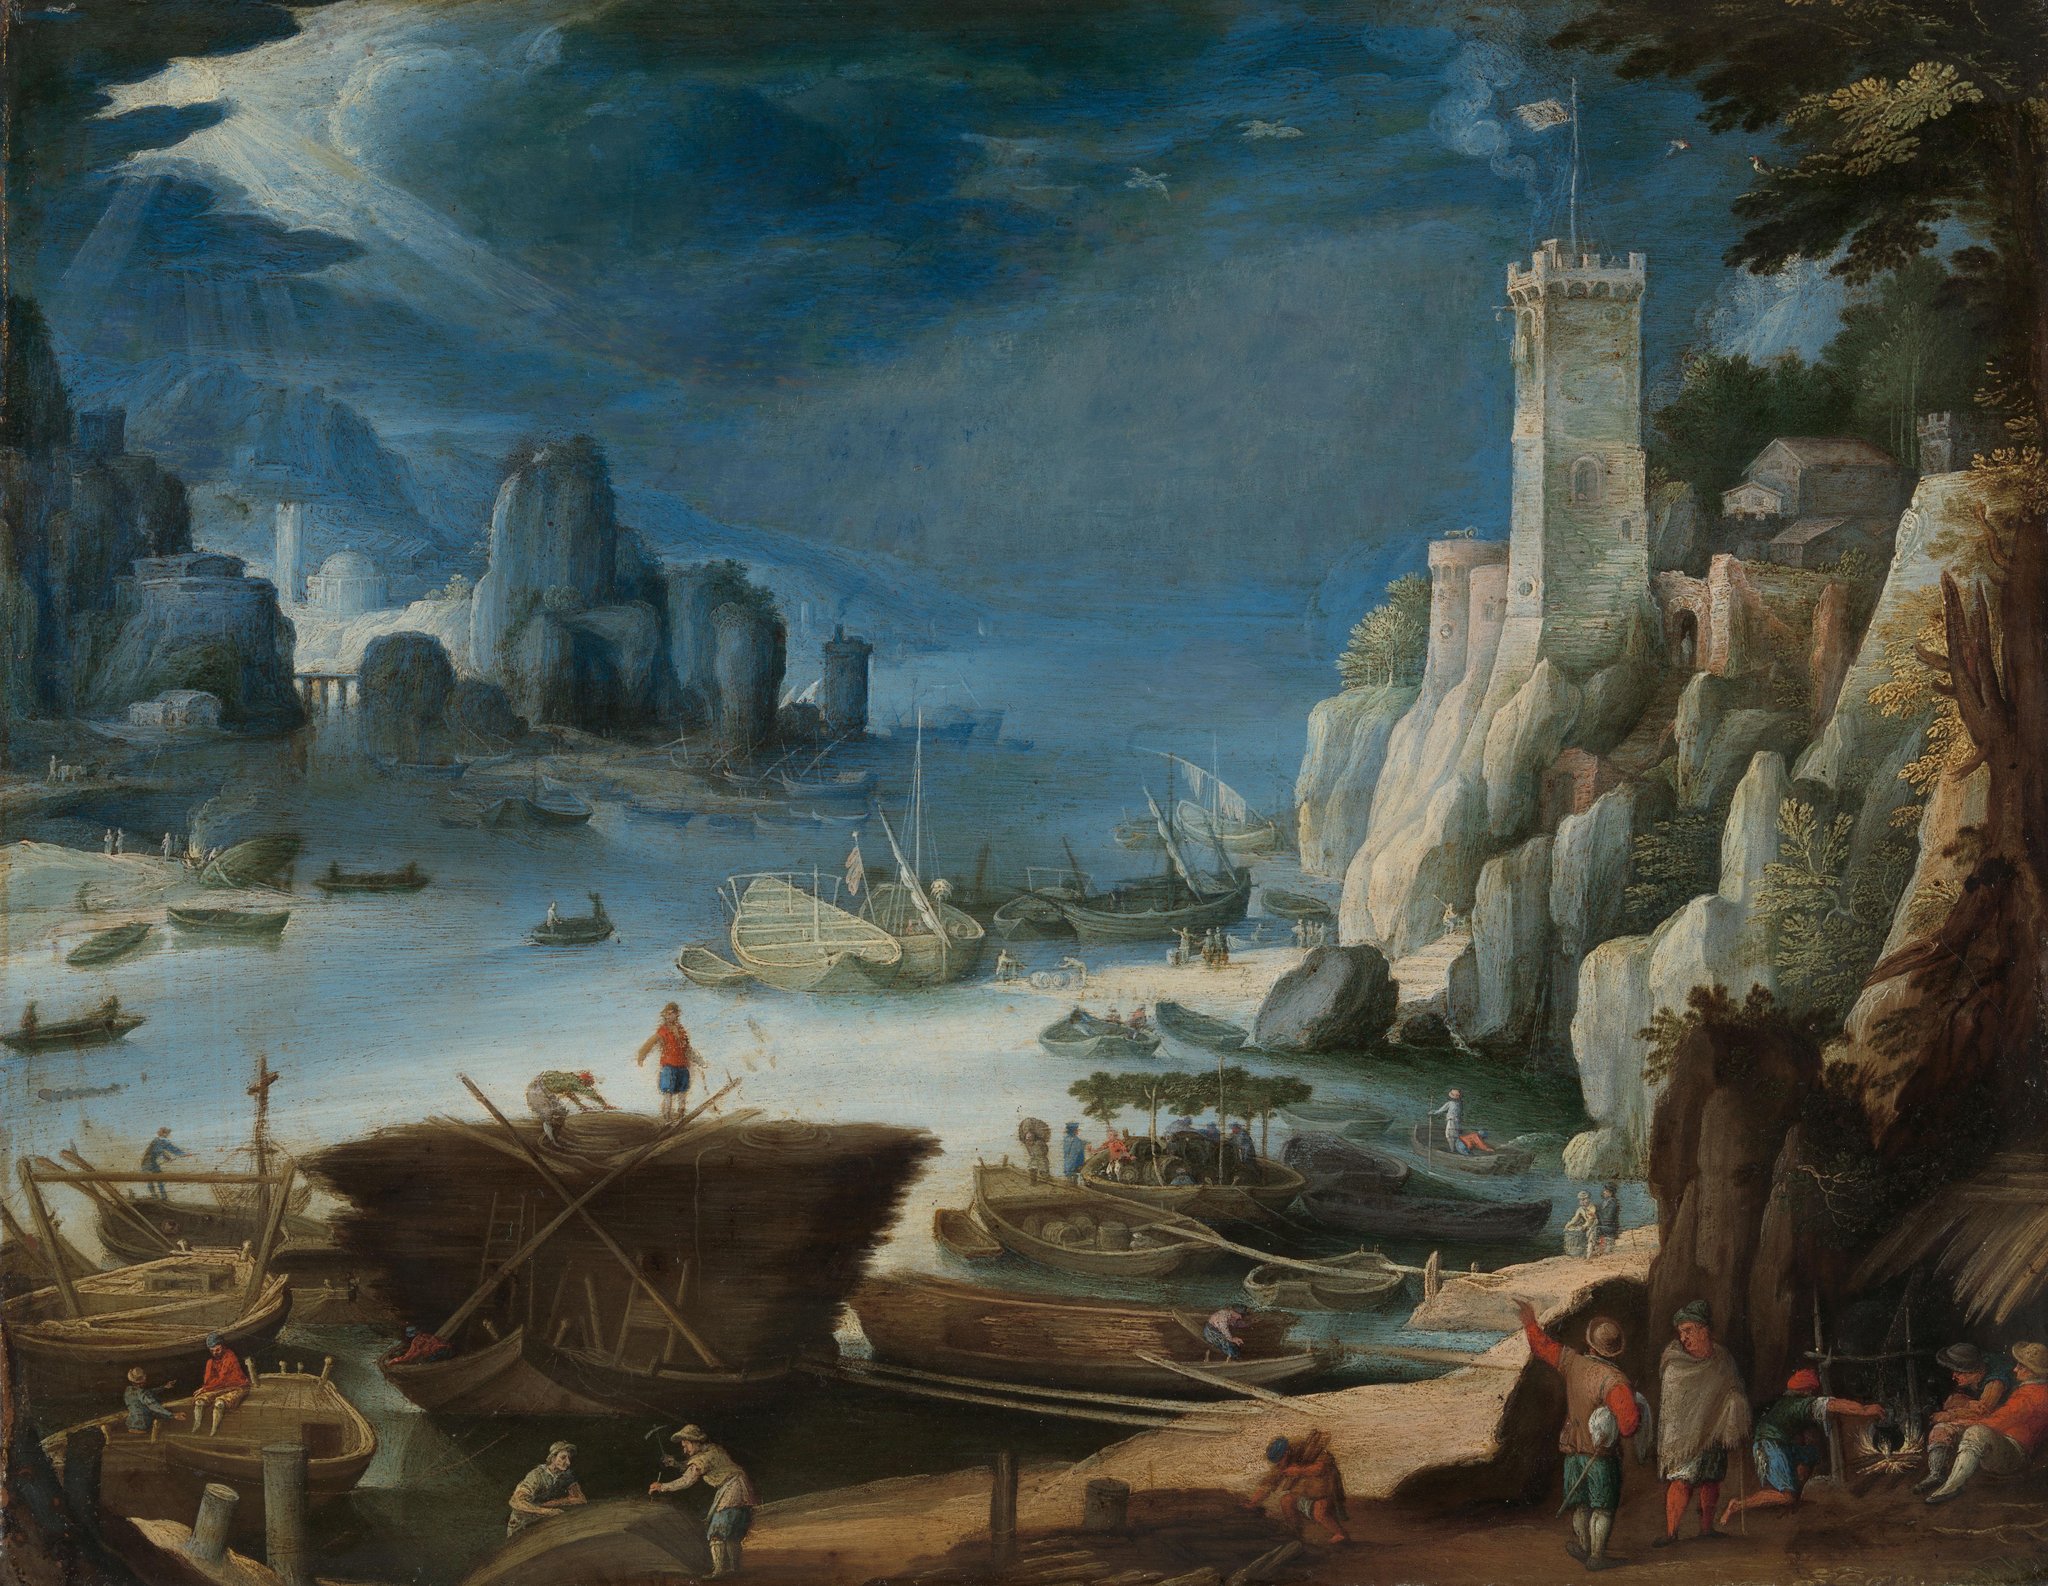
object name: painting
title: River view wit Large Rock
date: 1601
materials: copper, oil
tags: river, rocks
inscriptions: date: ‘[1]601’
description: Riviergezicht met rotsen. Kustlandschap met de monding van een rivier. Aan de oevers liggen vele schepen, sommige worden gerepareerd. Rechts op de voorgrond zitten figuren rond een ketel op een vuur. In de verte een vestingtoren.